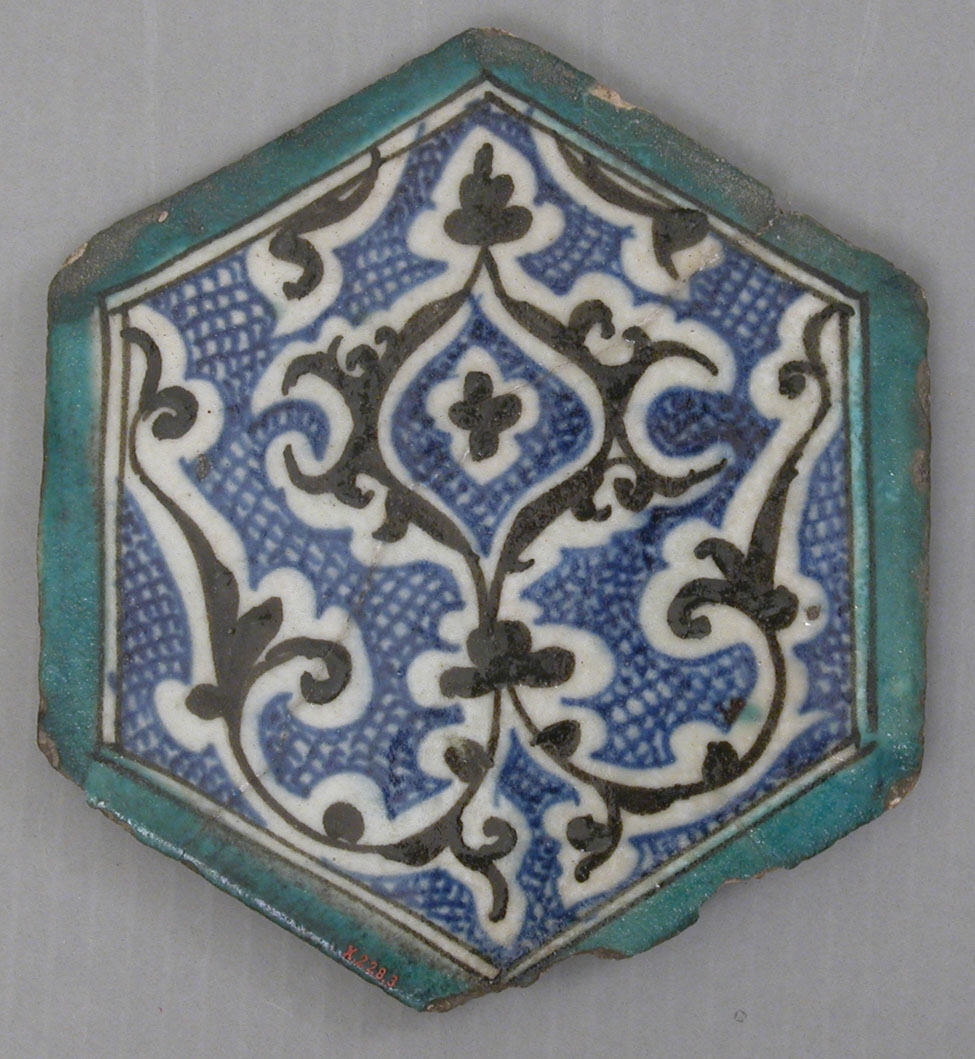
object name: tile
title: Hexagonal Tile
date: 1401-1600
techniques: glazing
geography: egypt or syria